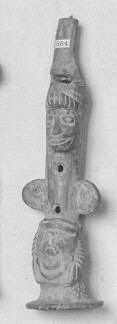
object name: pottery whistle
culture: mexican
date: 1801-1900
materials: clay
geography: mexico